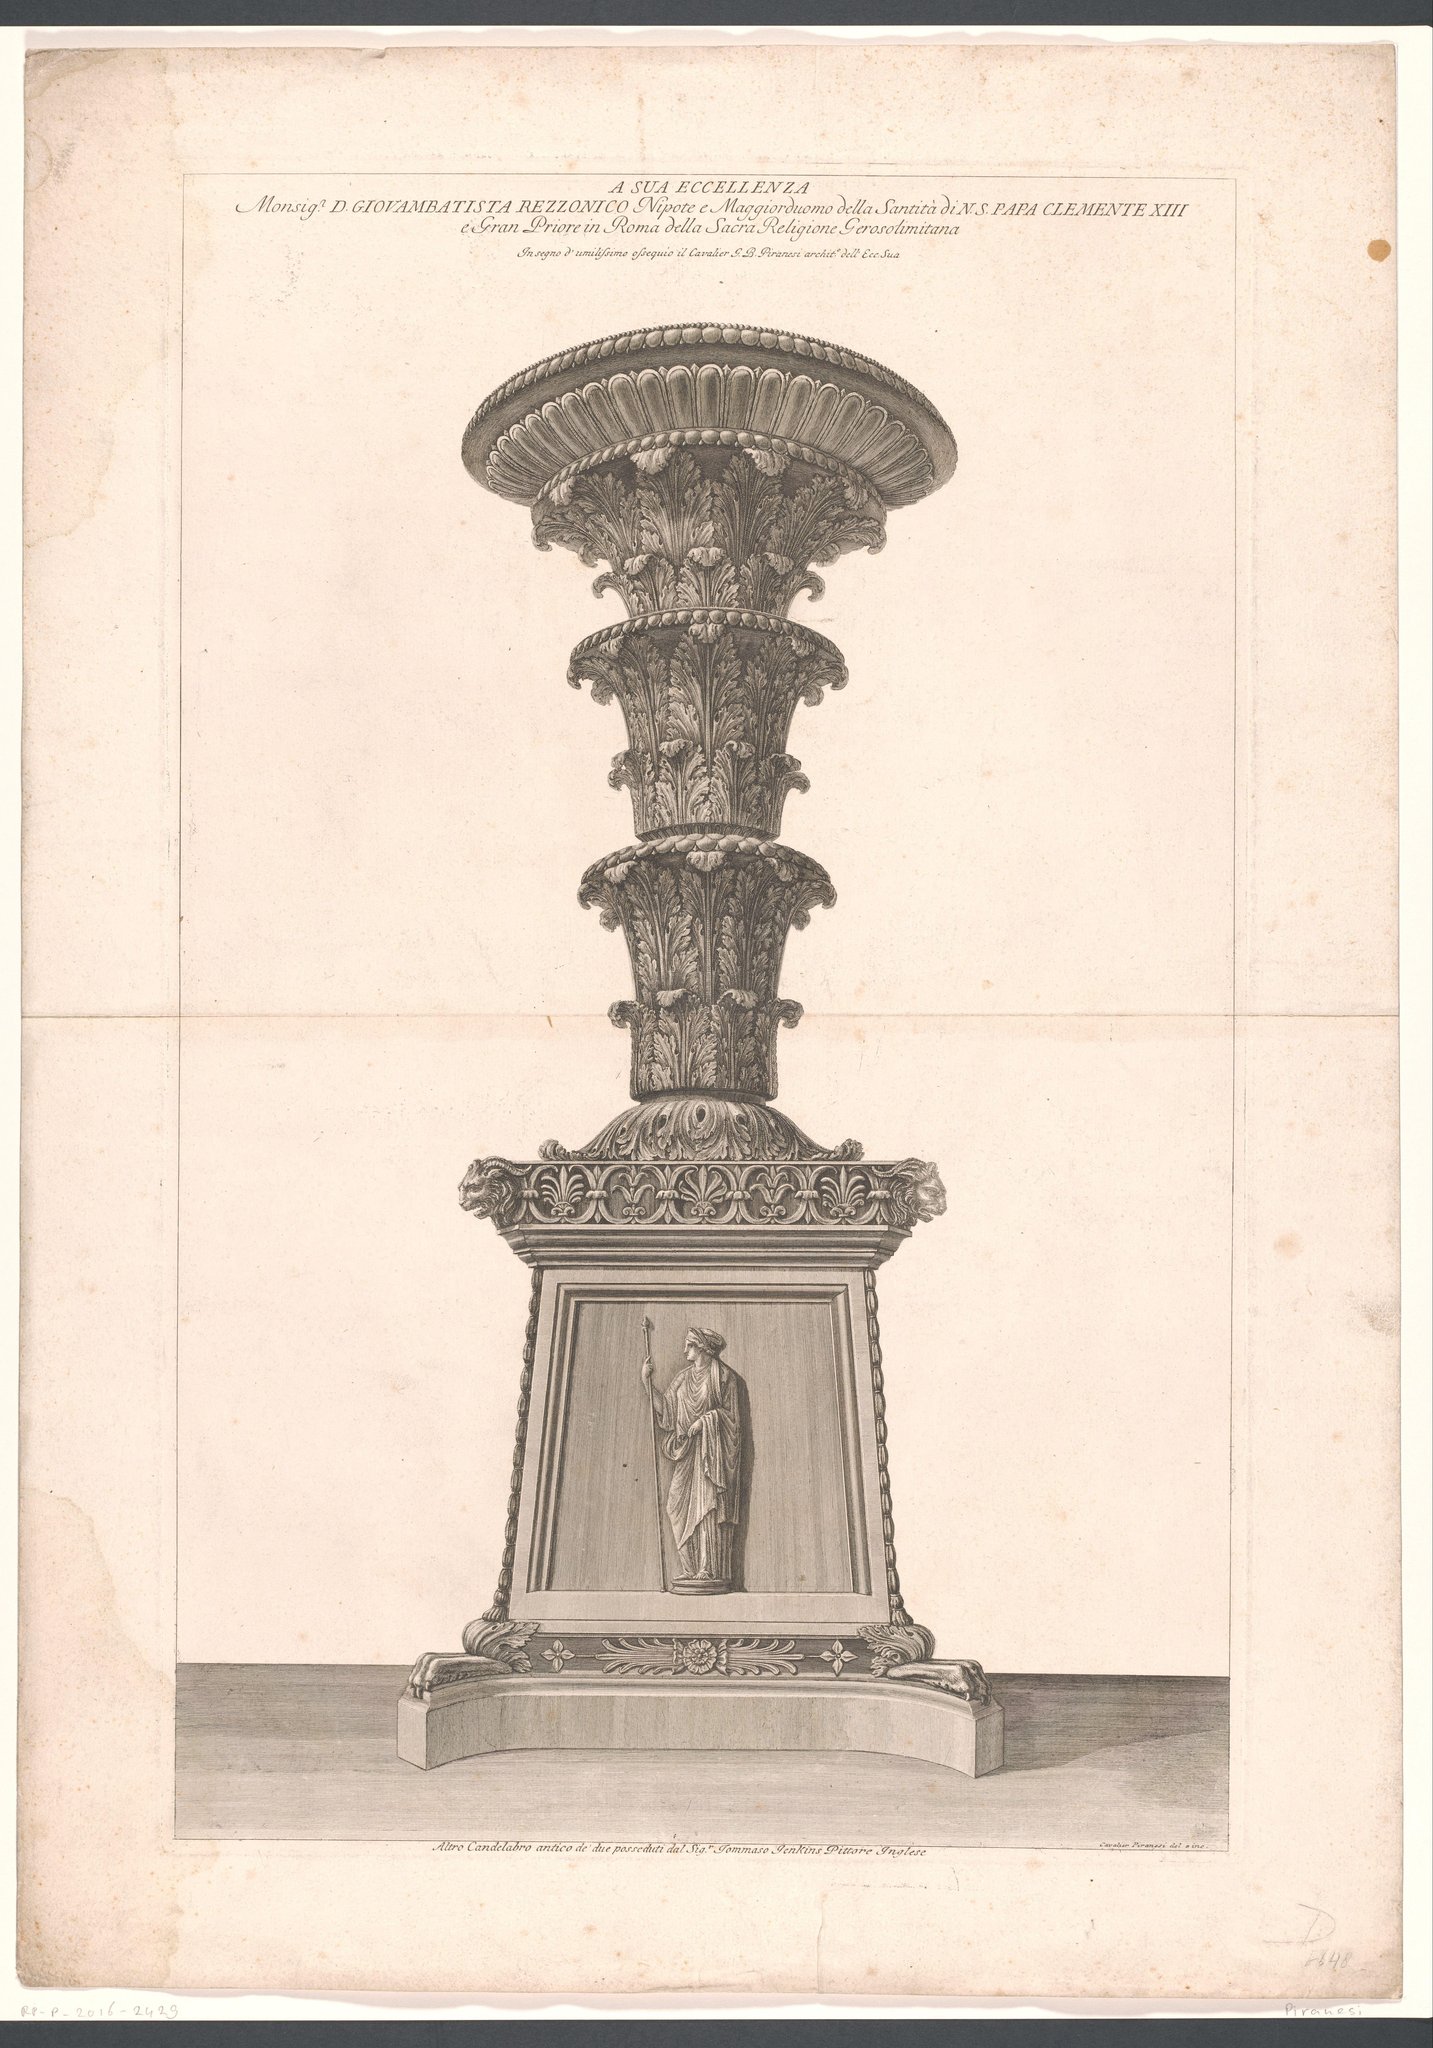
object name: ornament print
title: Vasi, candelabri, cippi, sarcofagi, tripodi, lucerne, ed ornamenti antichi disegn. ed incisi dal cav. Gio. Batta Piranesi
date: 1778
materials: paper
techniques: etching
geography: italy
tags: chandelier, candelabrum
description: De 'Vasi'-reeks telt 110 prenten, verspreid over twee volumes met elk een eigen titelprent. Piranesi werd voor deze reeks geholpen door verschillende assistenten uit zijn werkplaats, waaronder zijn zoon Francesco die ook nog eens 8 platen toevoegde aan de reeks in 1779-1780. De kandelaber wordt vandaag de dag bewaard in de Vaticaanse musea te Vaticaanstad.